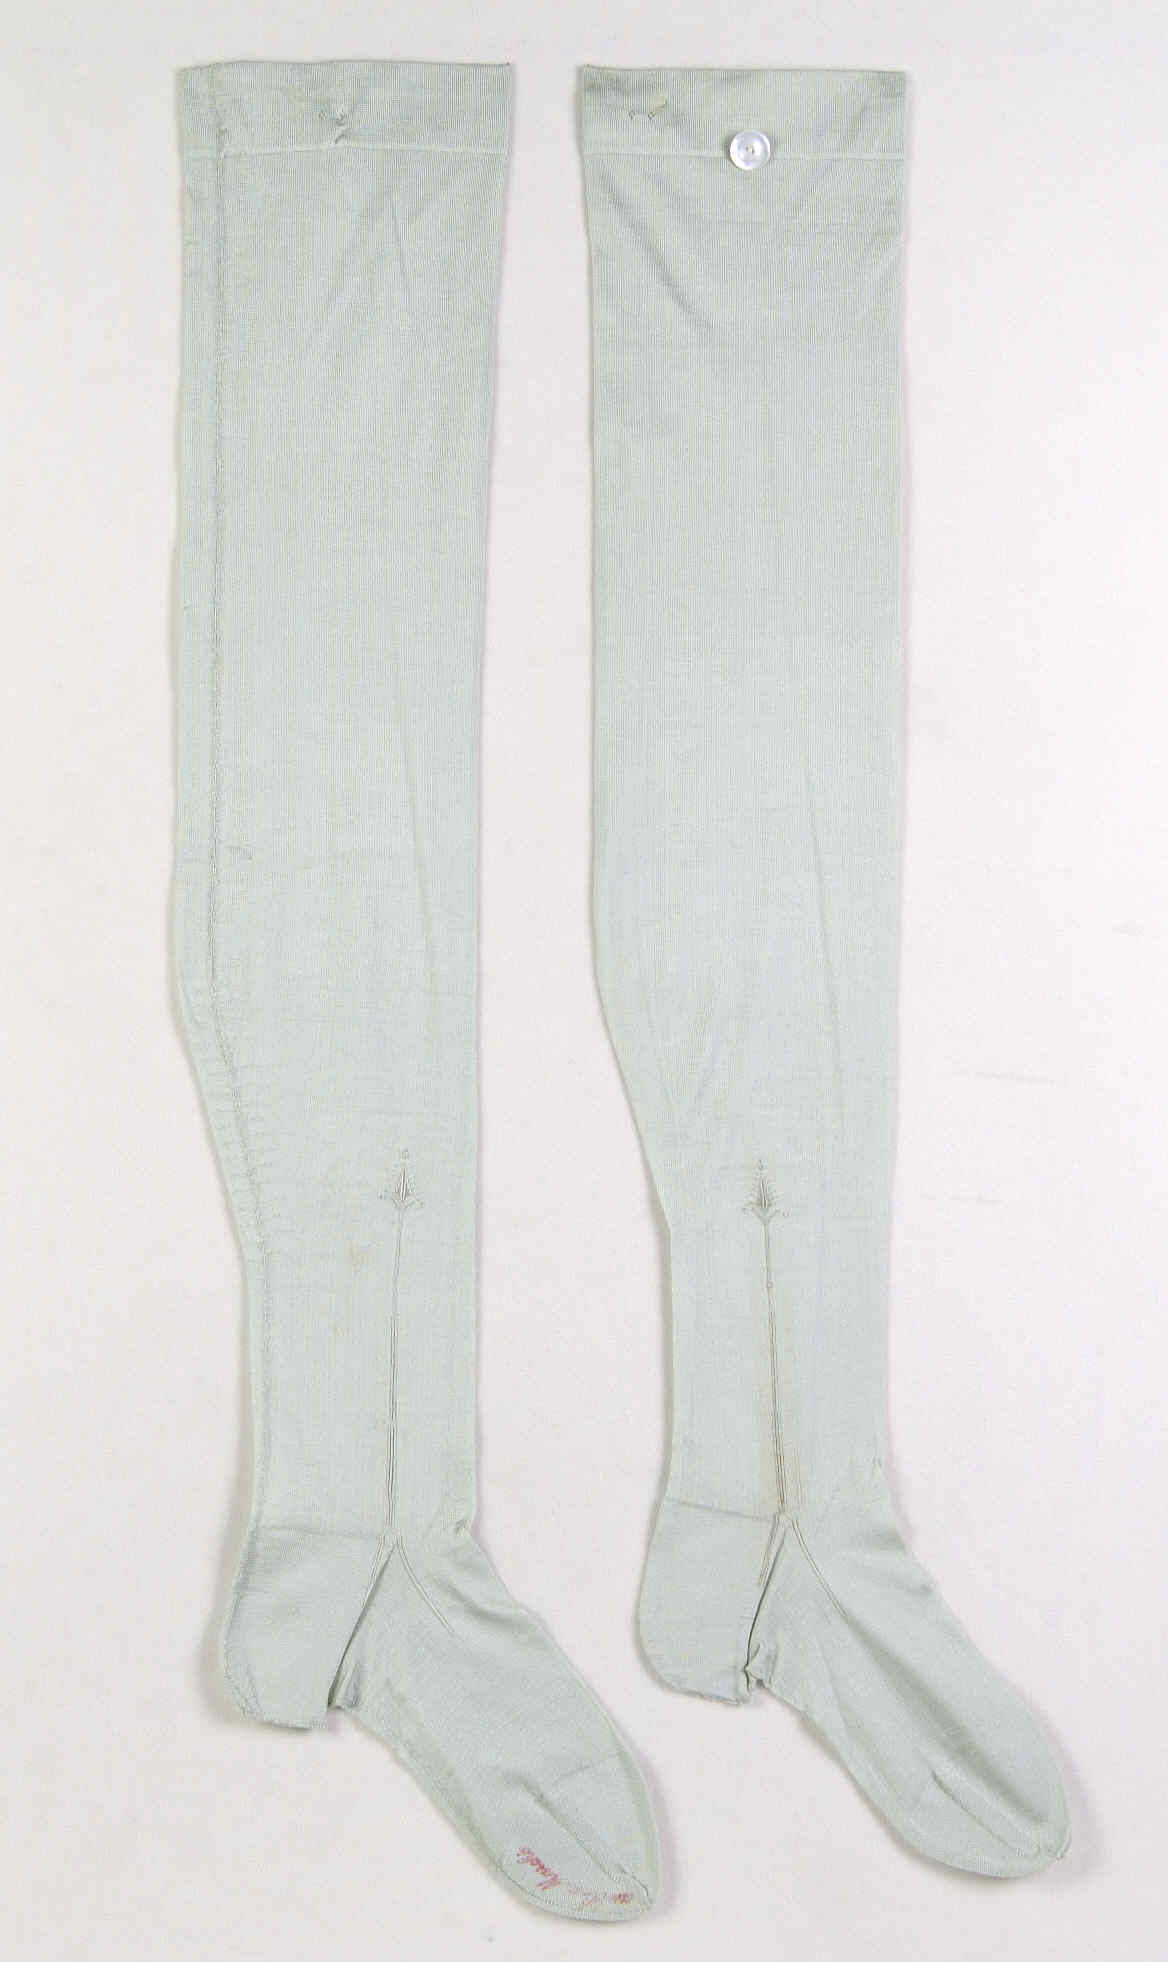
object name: stocking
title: Stockings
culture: french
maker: bon marché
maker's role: department store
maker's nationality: french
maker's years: 1852-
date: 1880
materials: silk